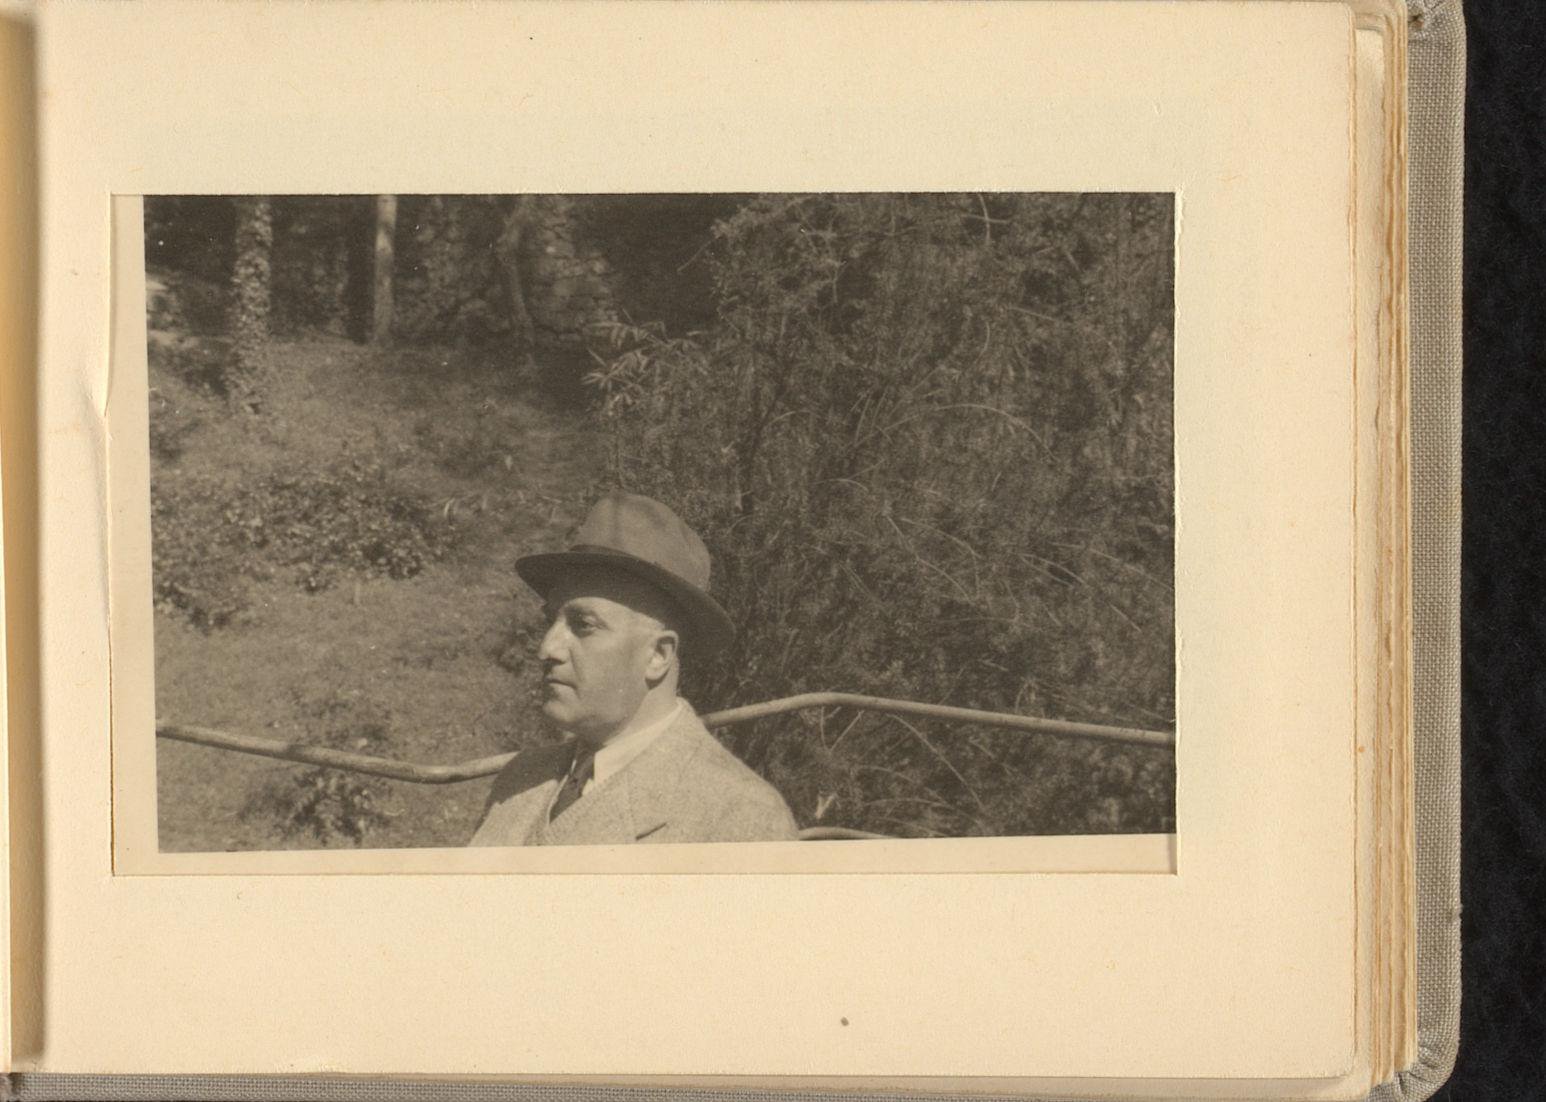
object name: photograph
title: Eugen Wachenheimer voor een hek in de openlucht, 1922-1937, Duitsland / Oostenrijk / Zwitserland?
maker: isabel wachenheimer-elon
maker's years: 1928-2010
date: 1922-1937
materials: paper, photographic support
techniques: gelatin silver print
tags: eugen wachenheimer, historical persons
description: Albumblad bevat een foto van Eugen Wachenheimer. Onderdeel van het fotoalbum met diverse foto's van de jeugd van Isabel Wachenheimer voor en tijdens de oorlog en diverse momenten van haar volwassen leven na de Tweede Wereldoorlog.